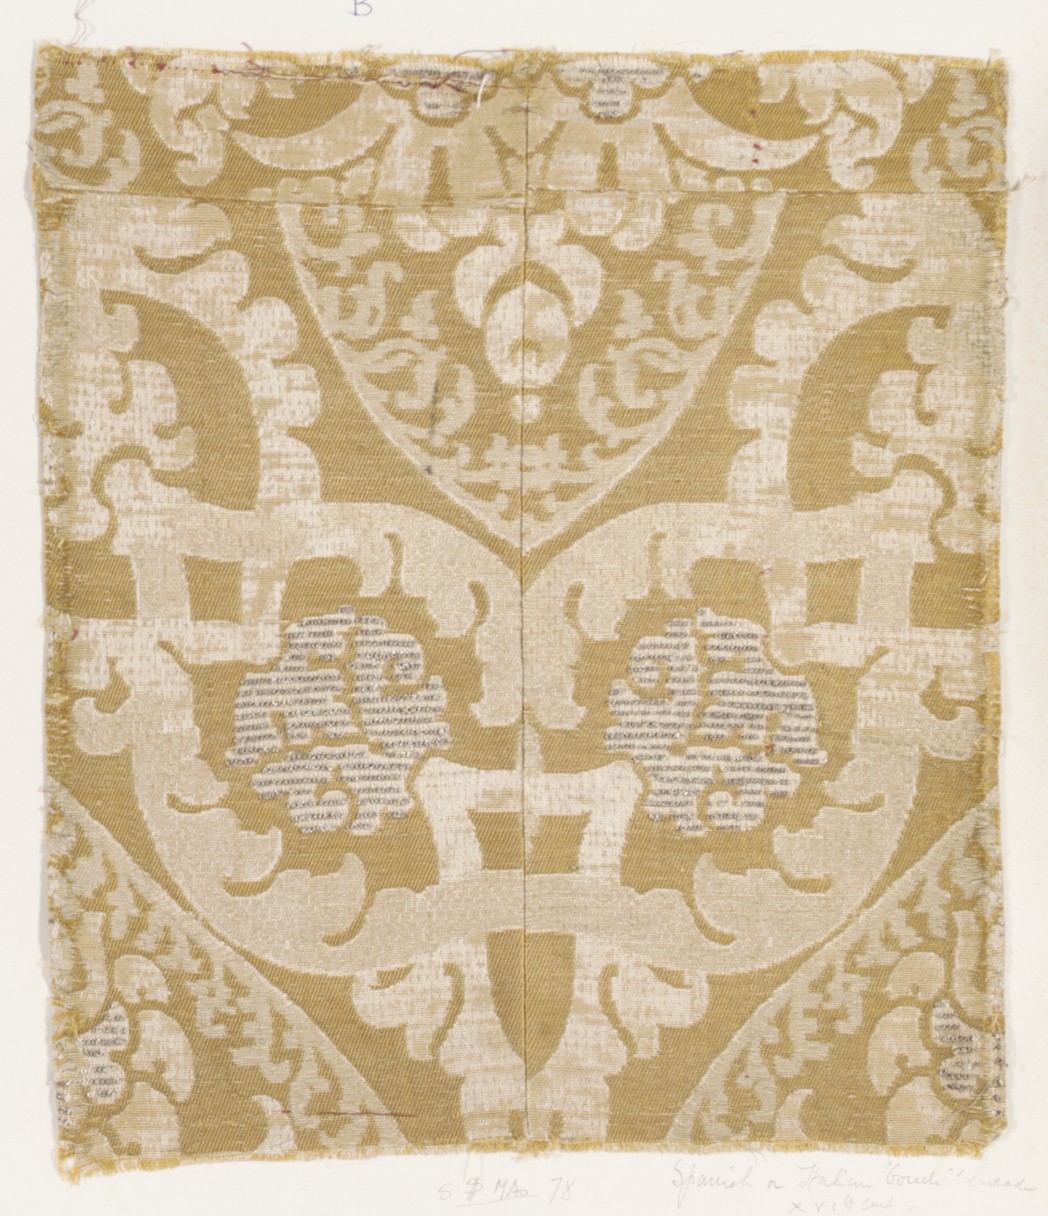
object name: fragment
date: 1501-1600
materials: metal thread, silk